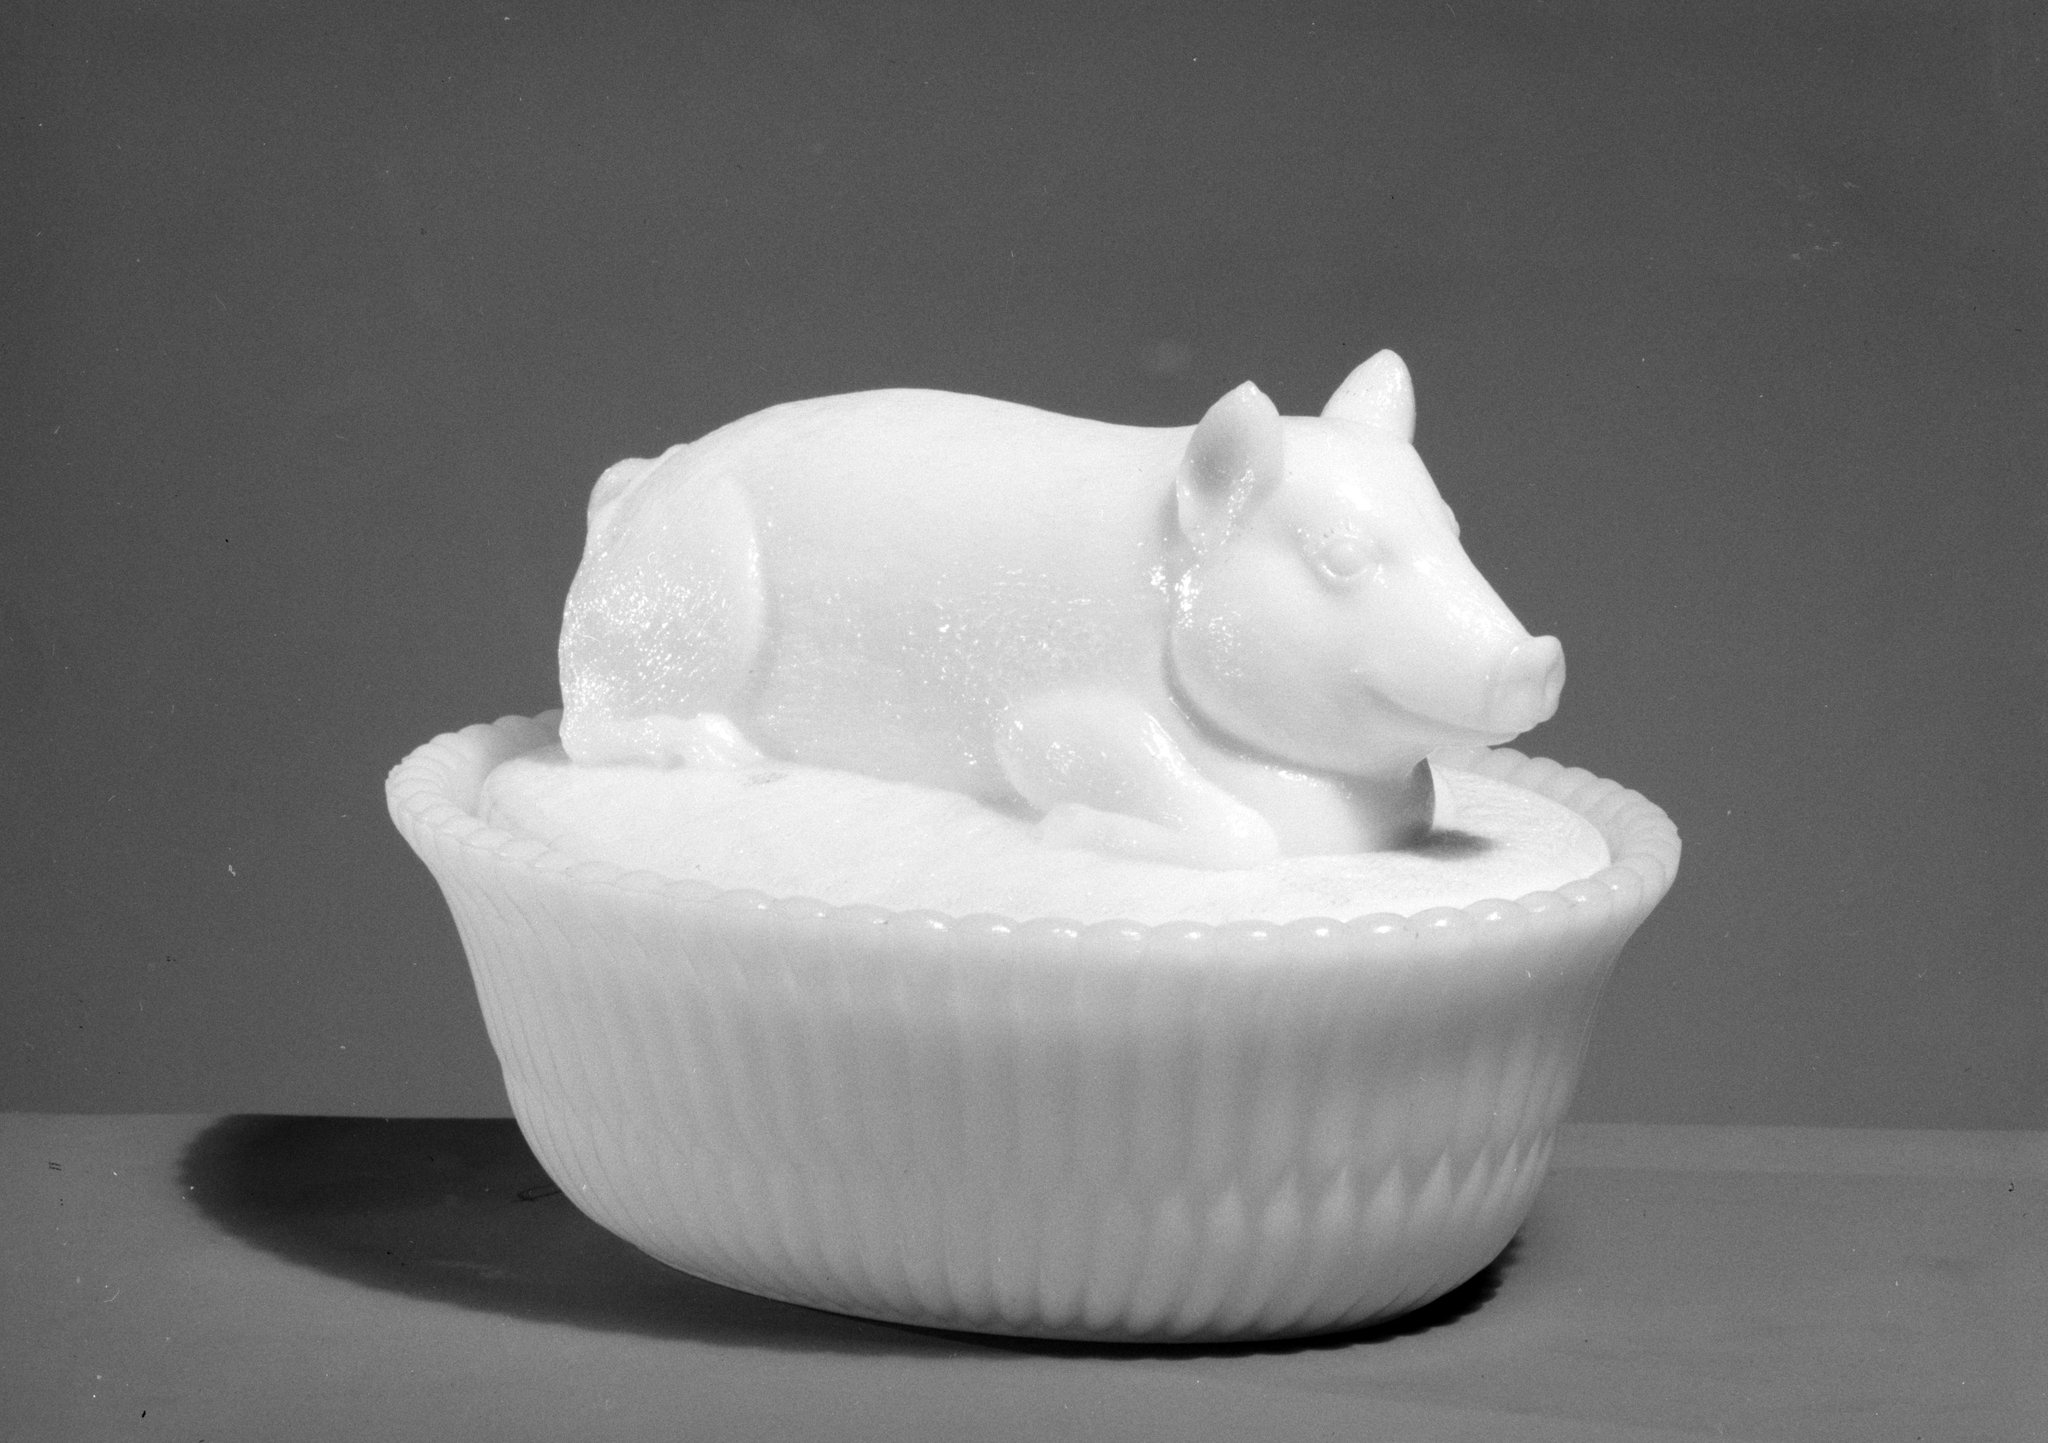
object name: dish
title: Figure Dish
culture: american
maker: mckee and brothers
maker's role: maker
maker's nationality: american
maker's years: 1856-1889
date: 1880-1890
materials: glass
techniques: pressed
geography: united states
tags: pigs